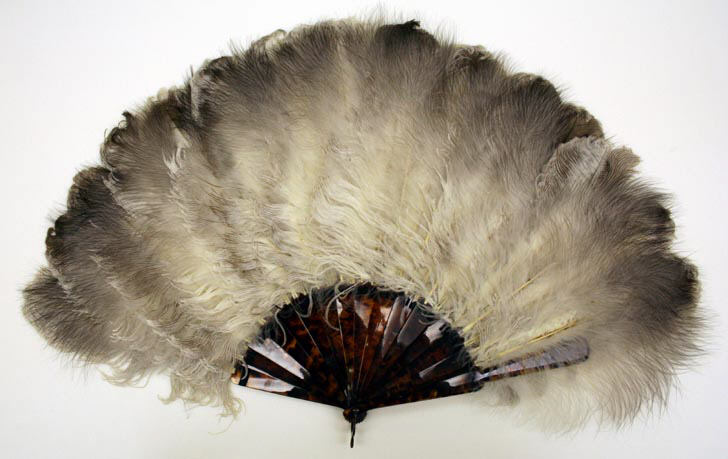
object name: fan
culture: american or european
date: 1890-1899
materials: feather, plastic